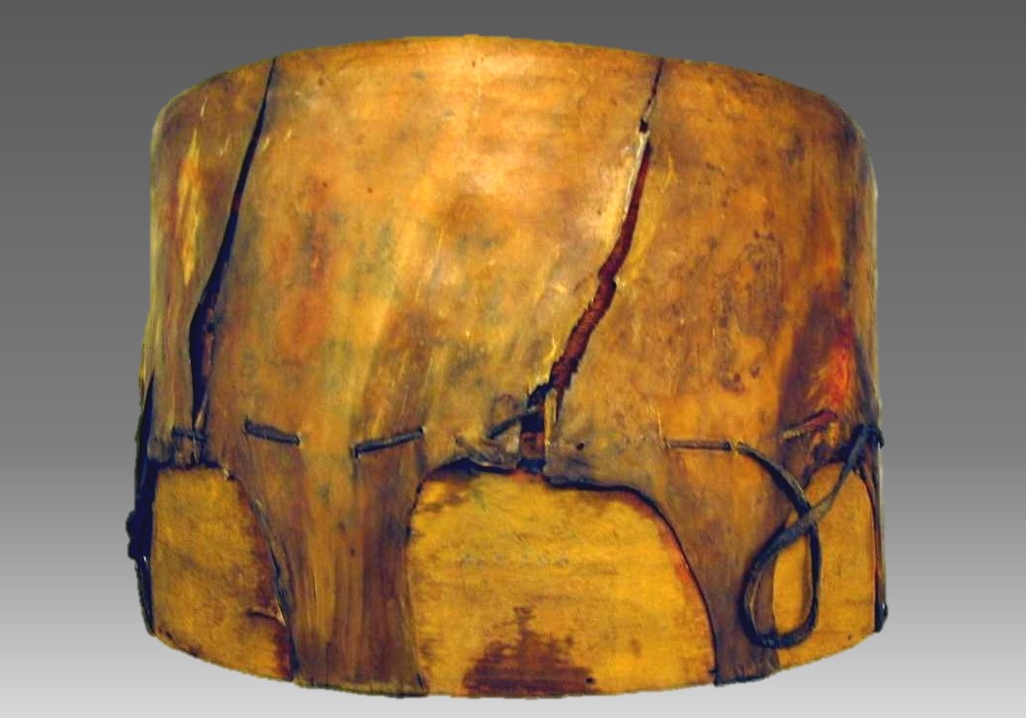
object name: frame drum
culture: native american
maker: shonshone / shoshonean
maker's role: maker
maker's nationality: native american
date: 1801-1900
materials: skin, wood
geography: united states